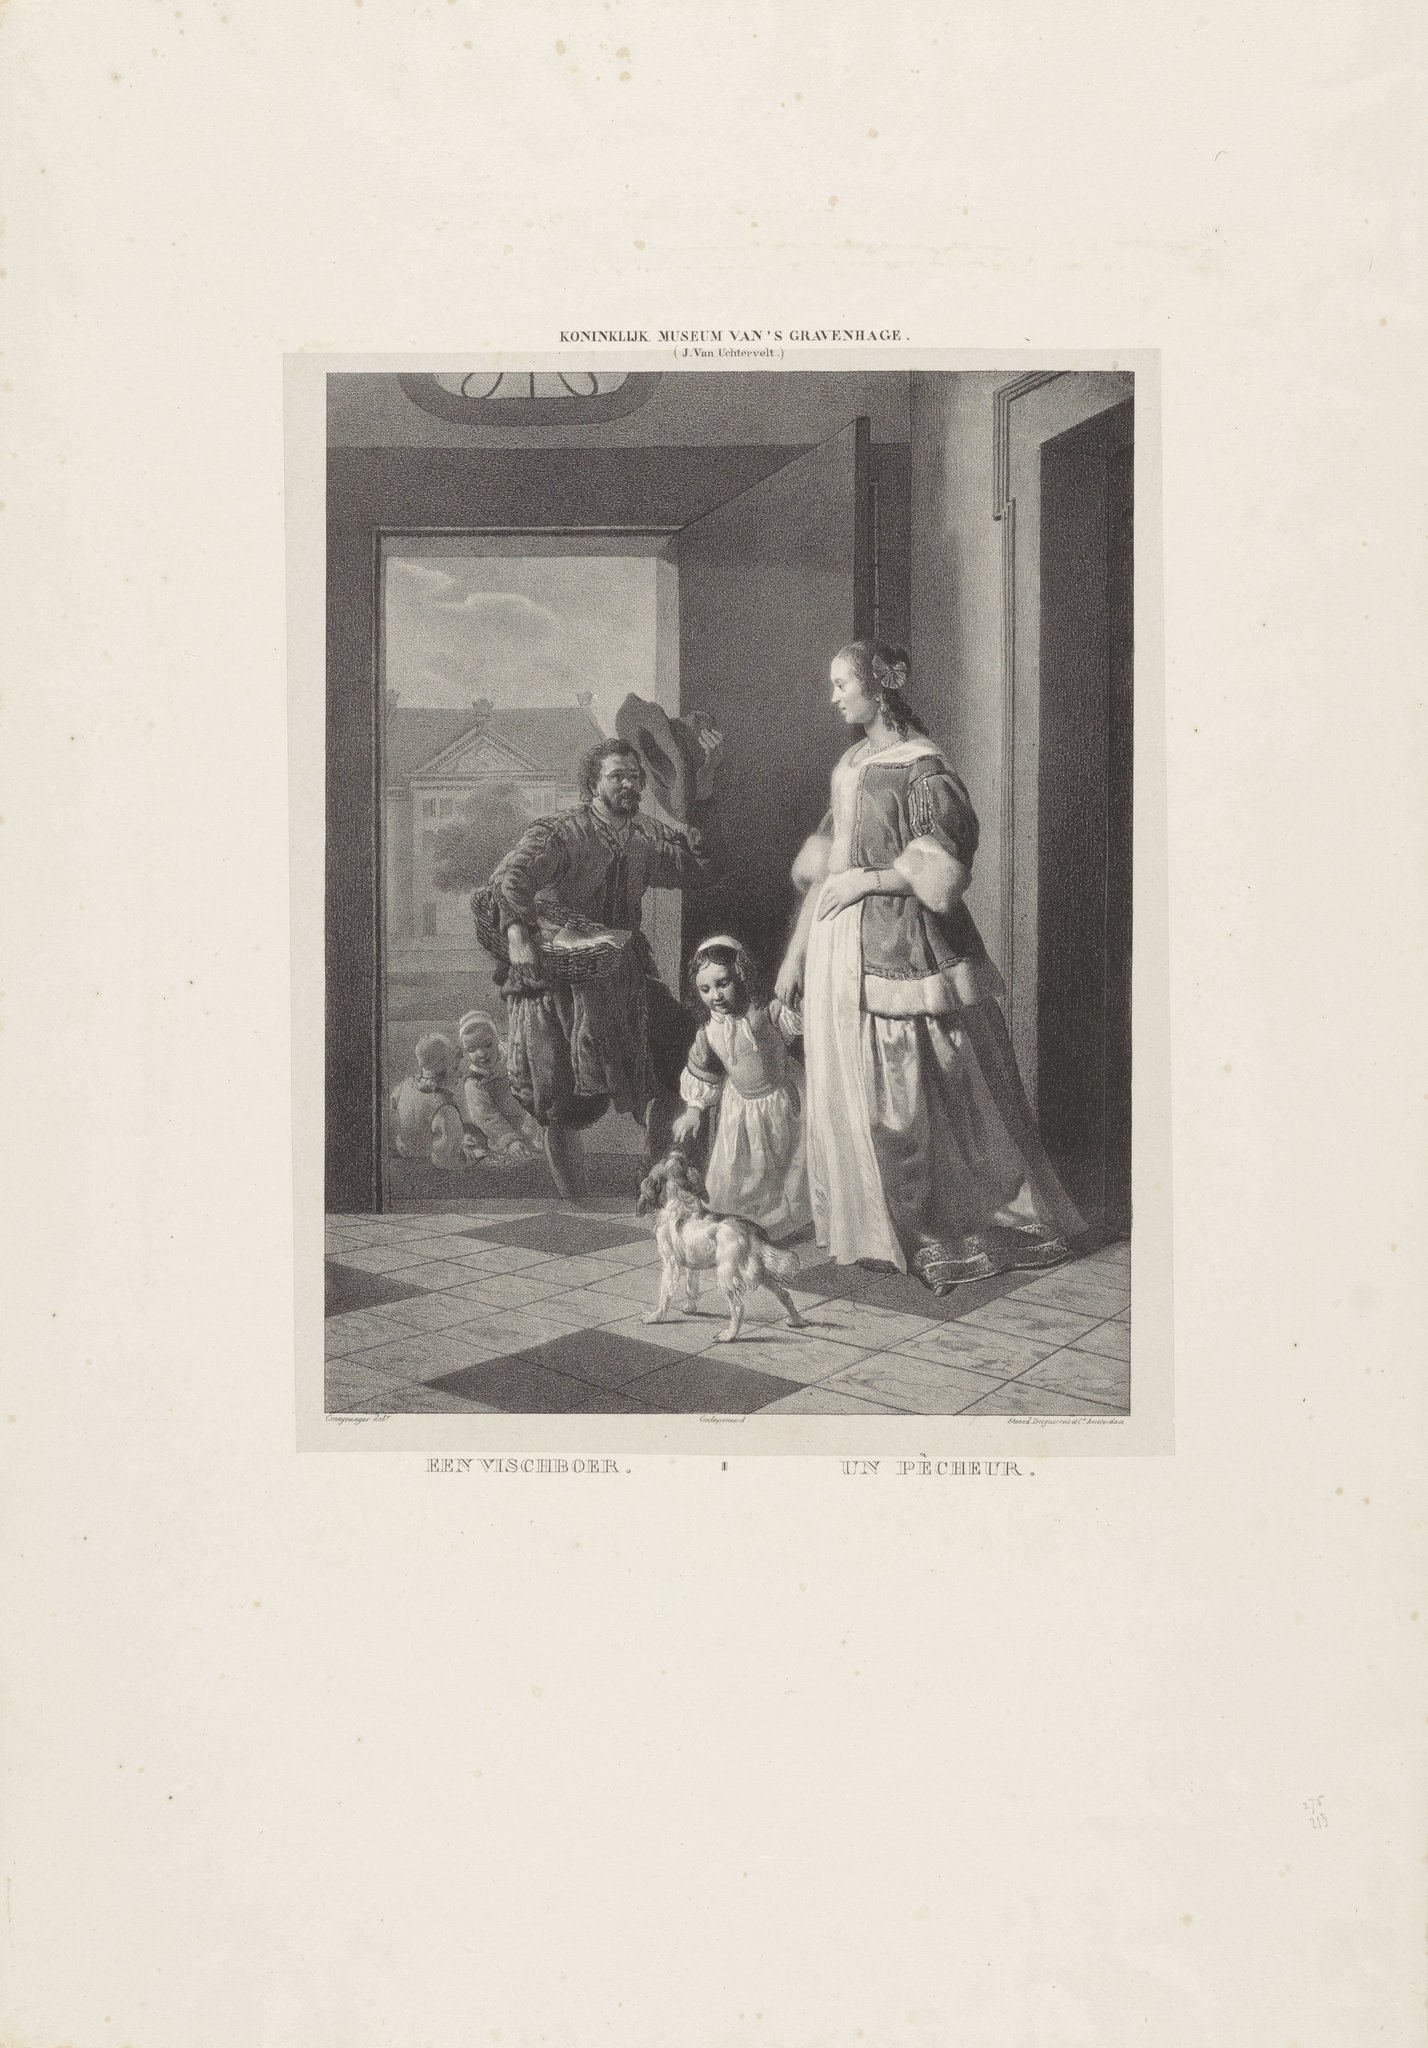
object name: print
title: Visverkoper aan de deur van een voornaam huis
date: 1833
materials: paper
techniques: lithograph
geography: amsterdam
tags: children's games and plays, fishes, opening the door, merchant, salesman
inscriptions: collector's mark: Lugt 2228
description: Een vrouw in een mantel afgezet met bont doet de deur open voor een visverkoper. Hij neemt zijn hoed af, onder zijn arm heeft hij een mand met vis. Aan haar arm heeft zij een jong meisje dat kijkt naar een hond. Achter de man, op de stoep, spelen twee kinderen. De prent werd gemaakt naar een schilderij van Jacob Ochtervelt in het Mauritshuis in Den Haag.